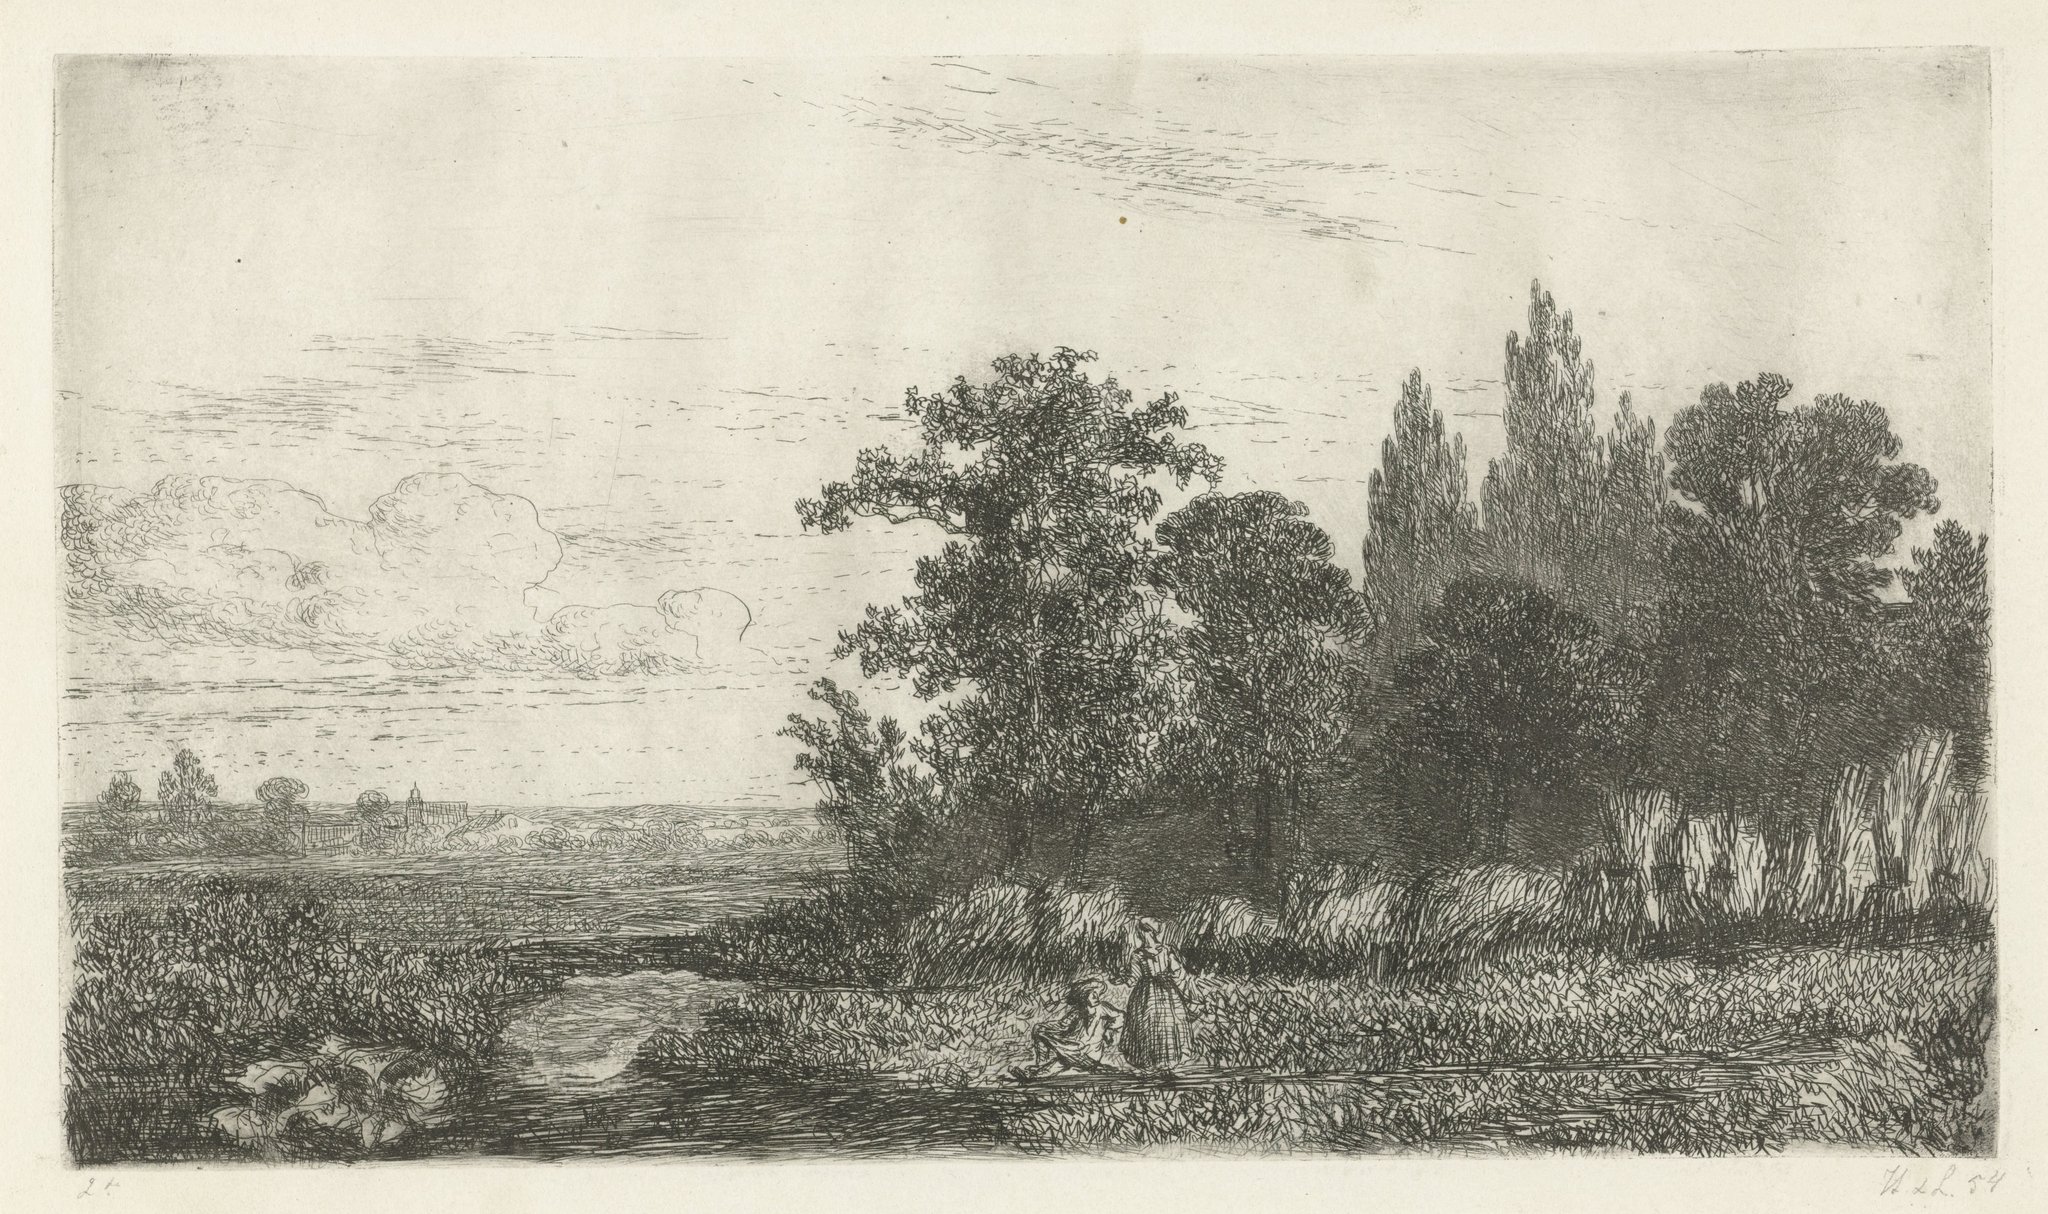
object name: print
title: Man en vrouw bij een beekje aan de bosrand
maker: hermanus jan hendrik van rijkelijkhuysen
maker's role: painter, print maker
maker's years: 1813-1883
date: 1857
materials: paper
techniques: drypoint, etching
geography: utrecht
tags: church (exterior), forest, wood, brook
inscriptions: collector's mark: Lugt 2228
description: Gezicht op de rand van een bos, waar zich bij een beekje een man en een vrouw bevinden. De man zit en de vrouw staat. Op de achtergrond de contouren van een kerk.